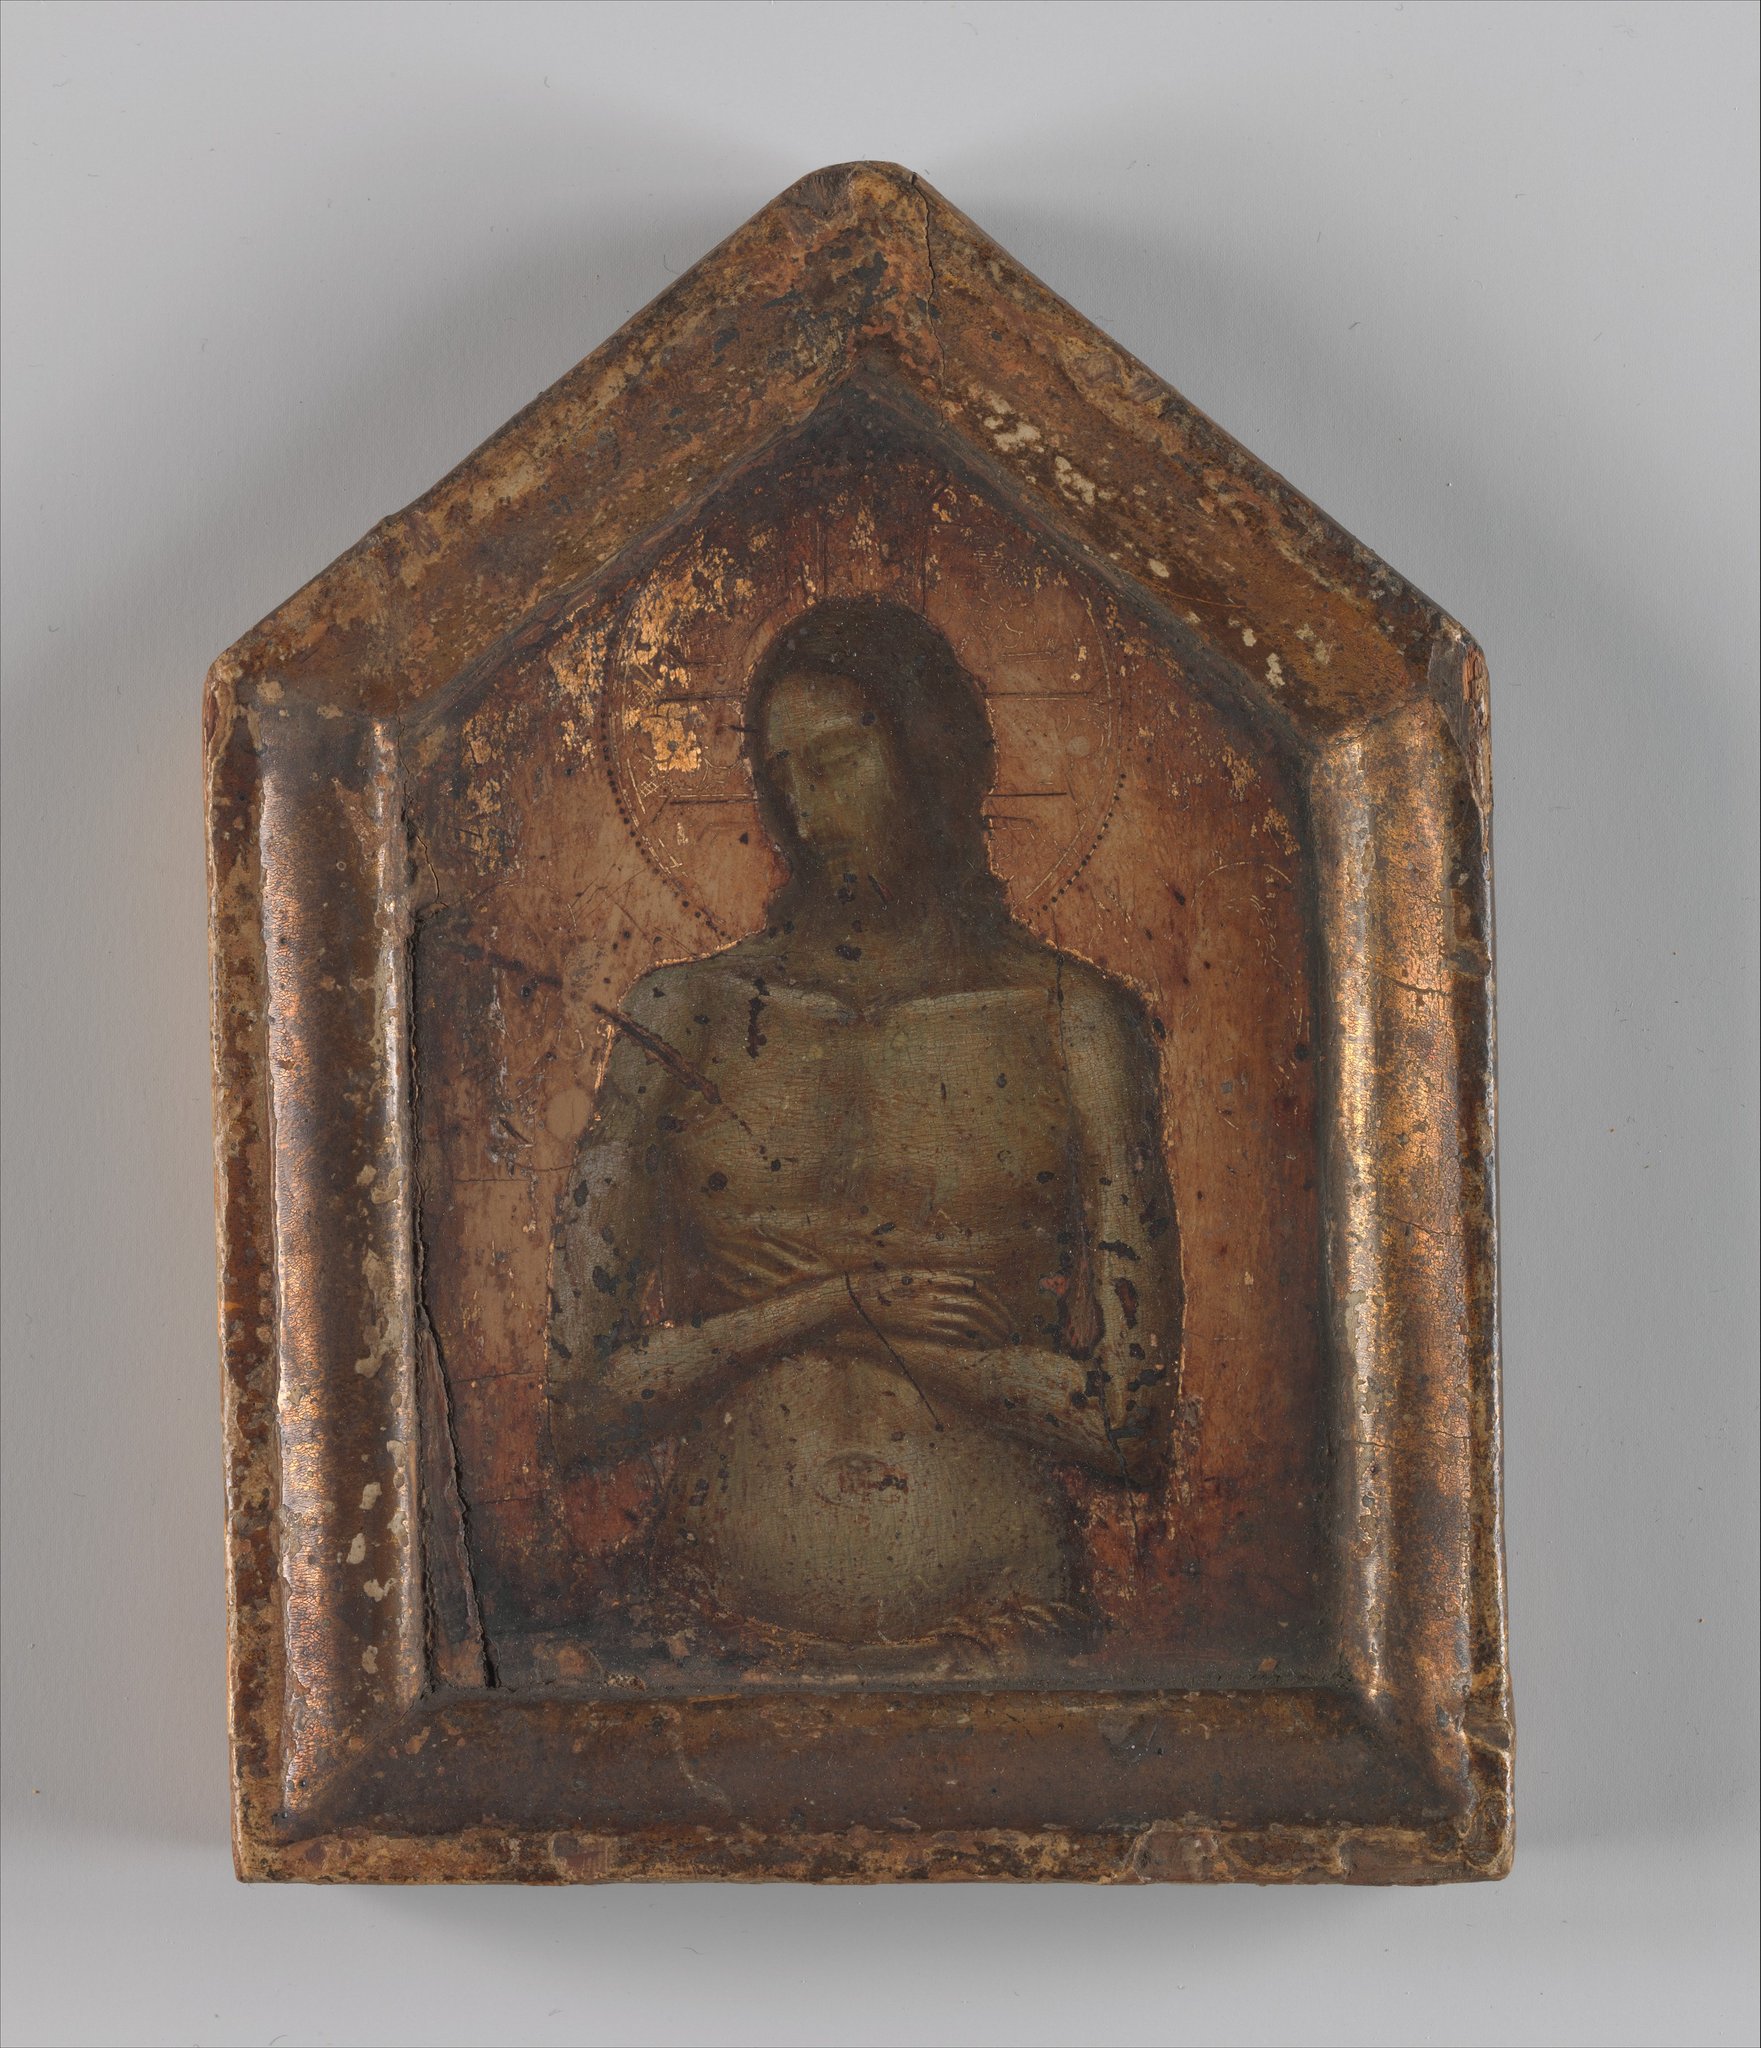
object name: painting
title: Pietà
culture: italian, tuscany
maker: italian [tuscan] painter, first quarter of 14th century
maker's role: artist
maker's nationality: italian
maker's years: 1300-1324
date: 1301-1325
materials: panel, paint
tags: christ